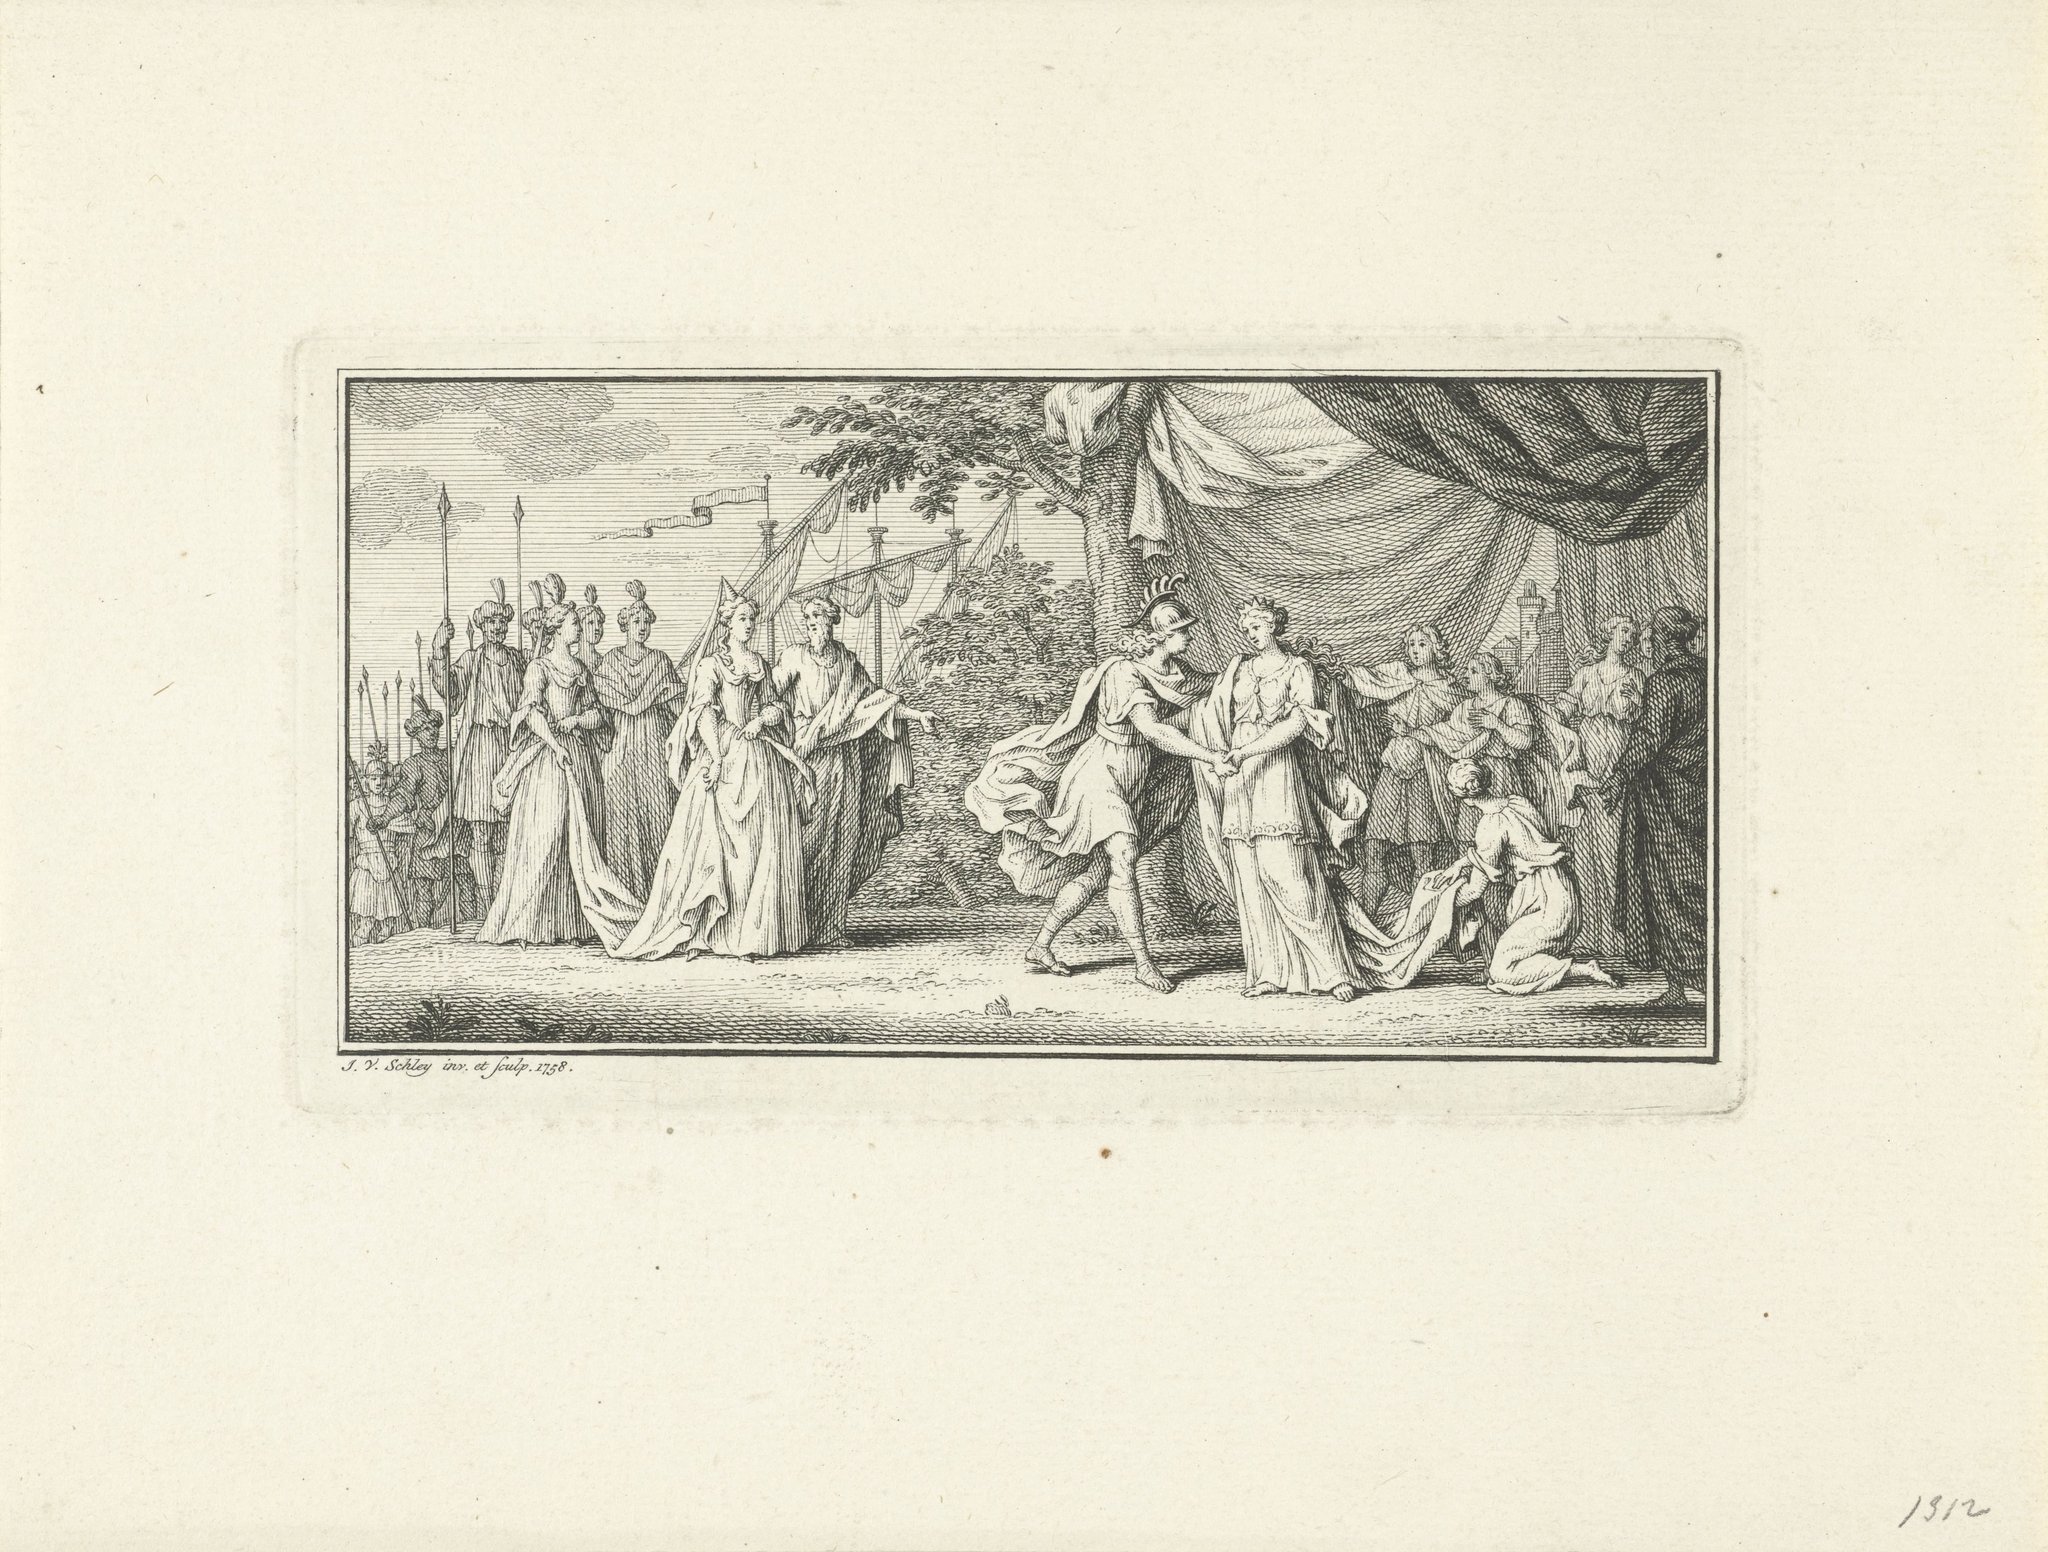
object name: print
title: Jonge soldaat begroet een prinses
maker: jacob van der schley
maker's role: draughtsman, print maker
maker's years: 1715-1779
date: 1758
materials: paper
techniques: engraving, etching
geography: amsterdam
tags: royal children - bb - female ruler, meeting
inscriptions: date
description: Een jonge soldaat begroet een prinses, achter haar het gevolg. Achter hem enkele jonkvrouwen en mannen met speren. Op de achtergrond scheepsmasten.